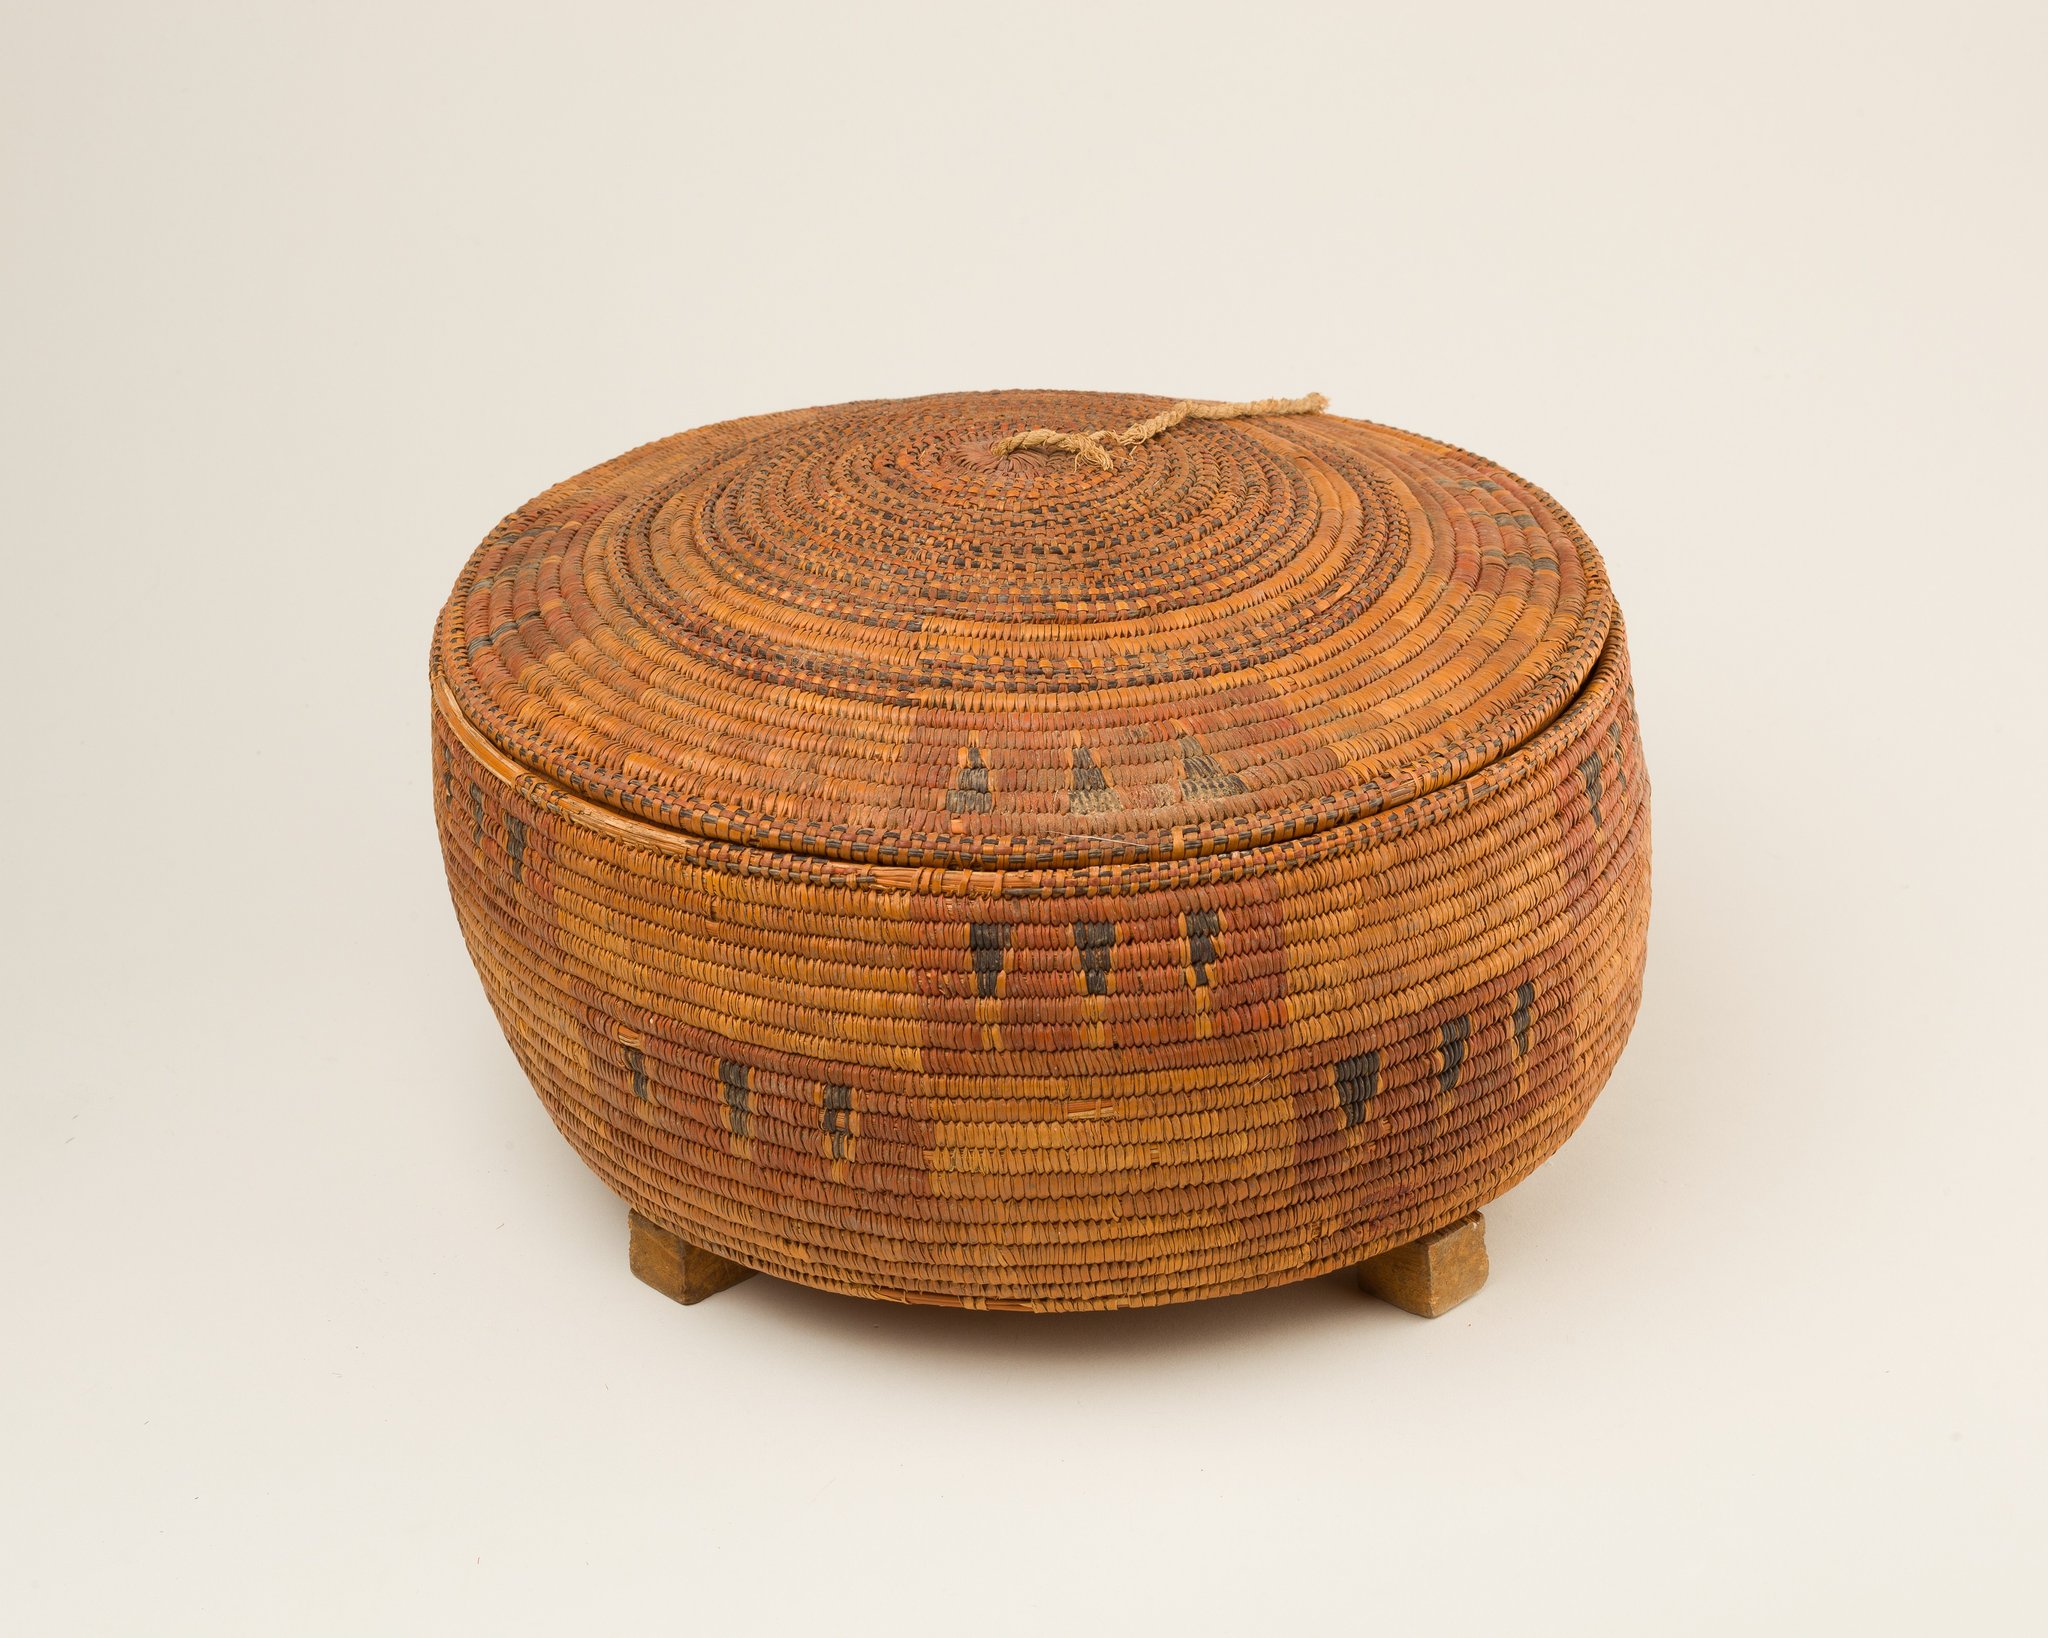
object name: basket, round, decorated, stand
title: Circular Lided Basket on a Wood Stand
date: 1492-1473 BCE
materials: cord, linen, leaf, wood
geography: egypt